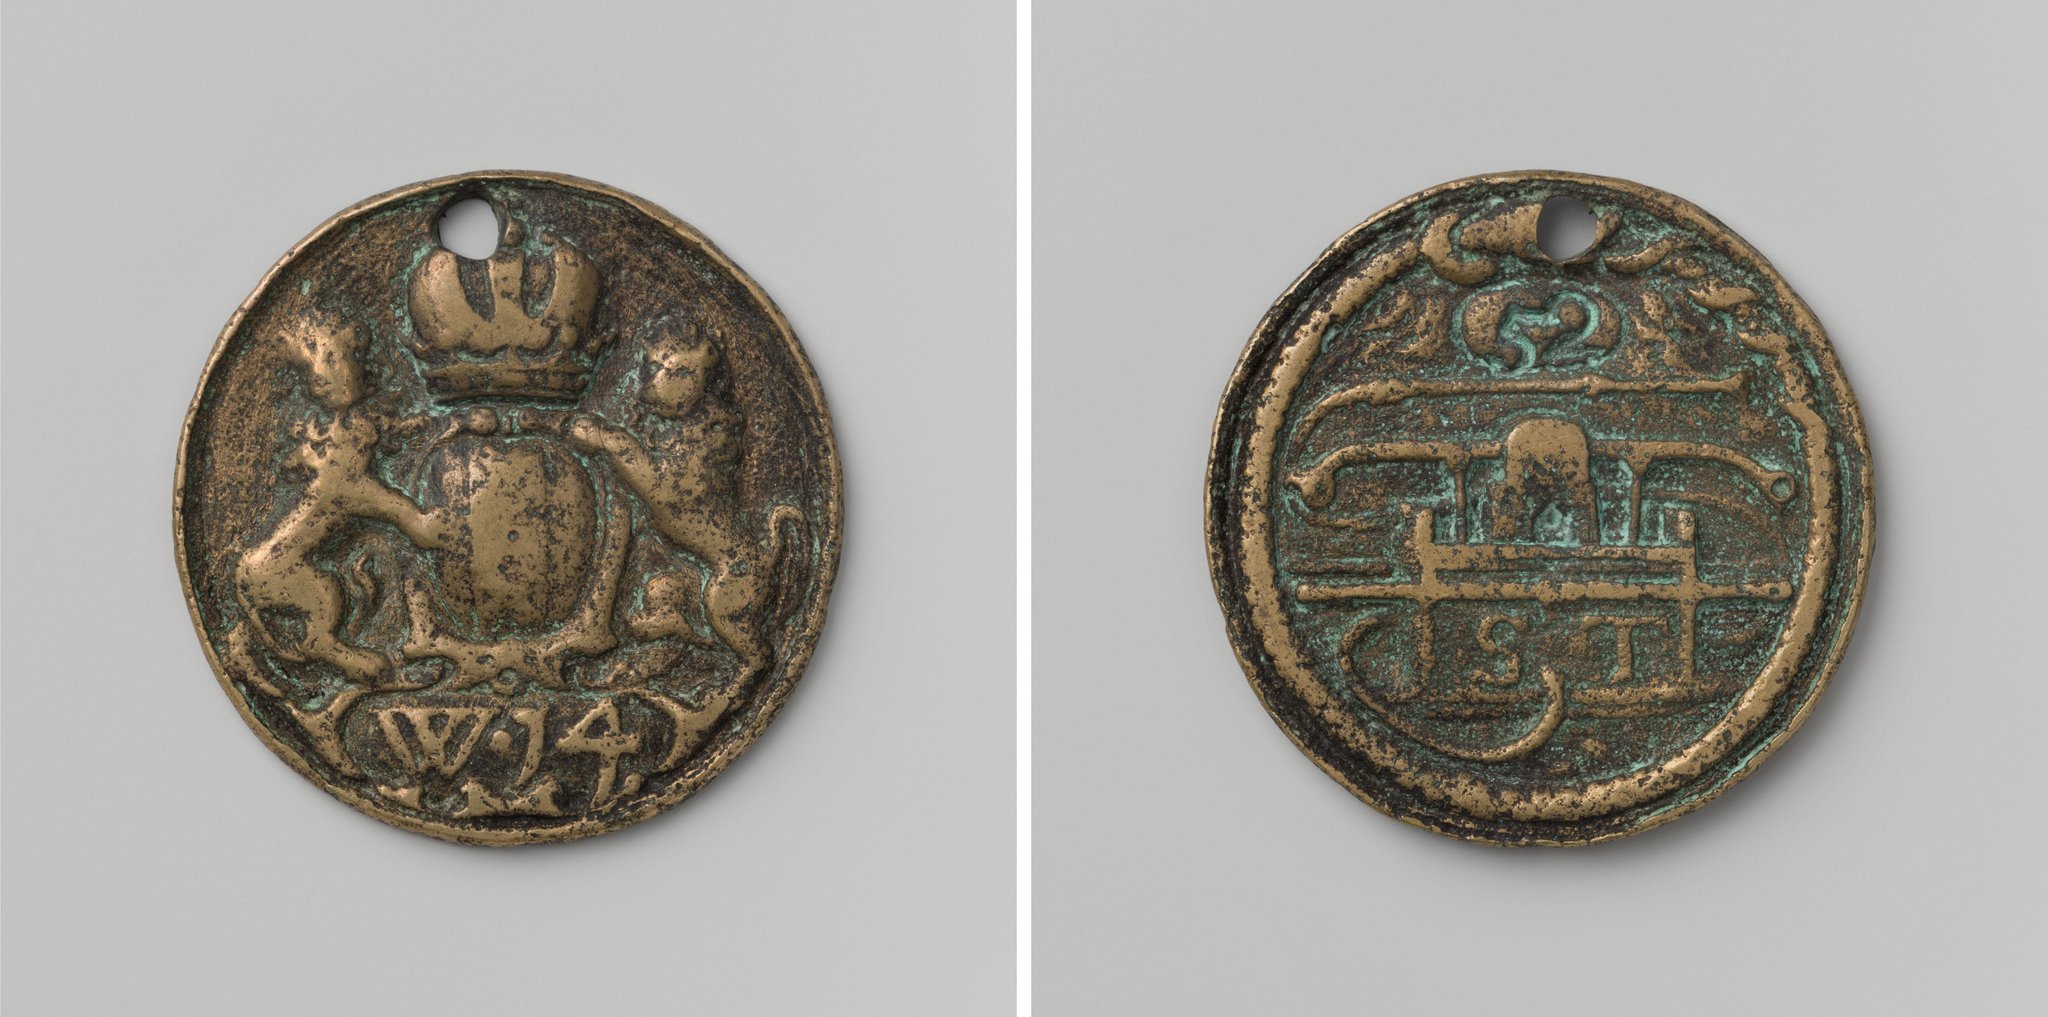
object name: fire engine medal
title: Amsterdam, brandspuitpenning van de wijk Stads Timmertuinen met no. 52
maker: Anonymous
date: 1680-1800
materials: brass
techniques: casting, engraving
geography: amsterdam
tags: stadstimmertuin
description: Messing penning met gat erin. Voorzijde: gekroond wapenschild, geflankeerd door twee leeuwen boven cartouche met opschrift W 14. Keerzijde: brandspuit onder cartouche met no. 52 binnen slangerond; op zijde van brandspuit: monogram van letters S.T.